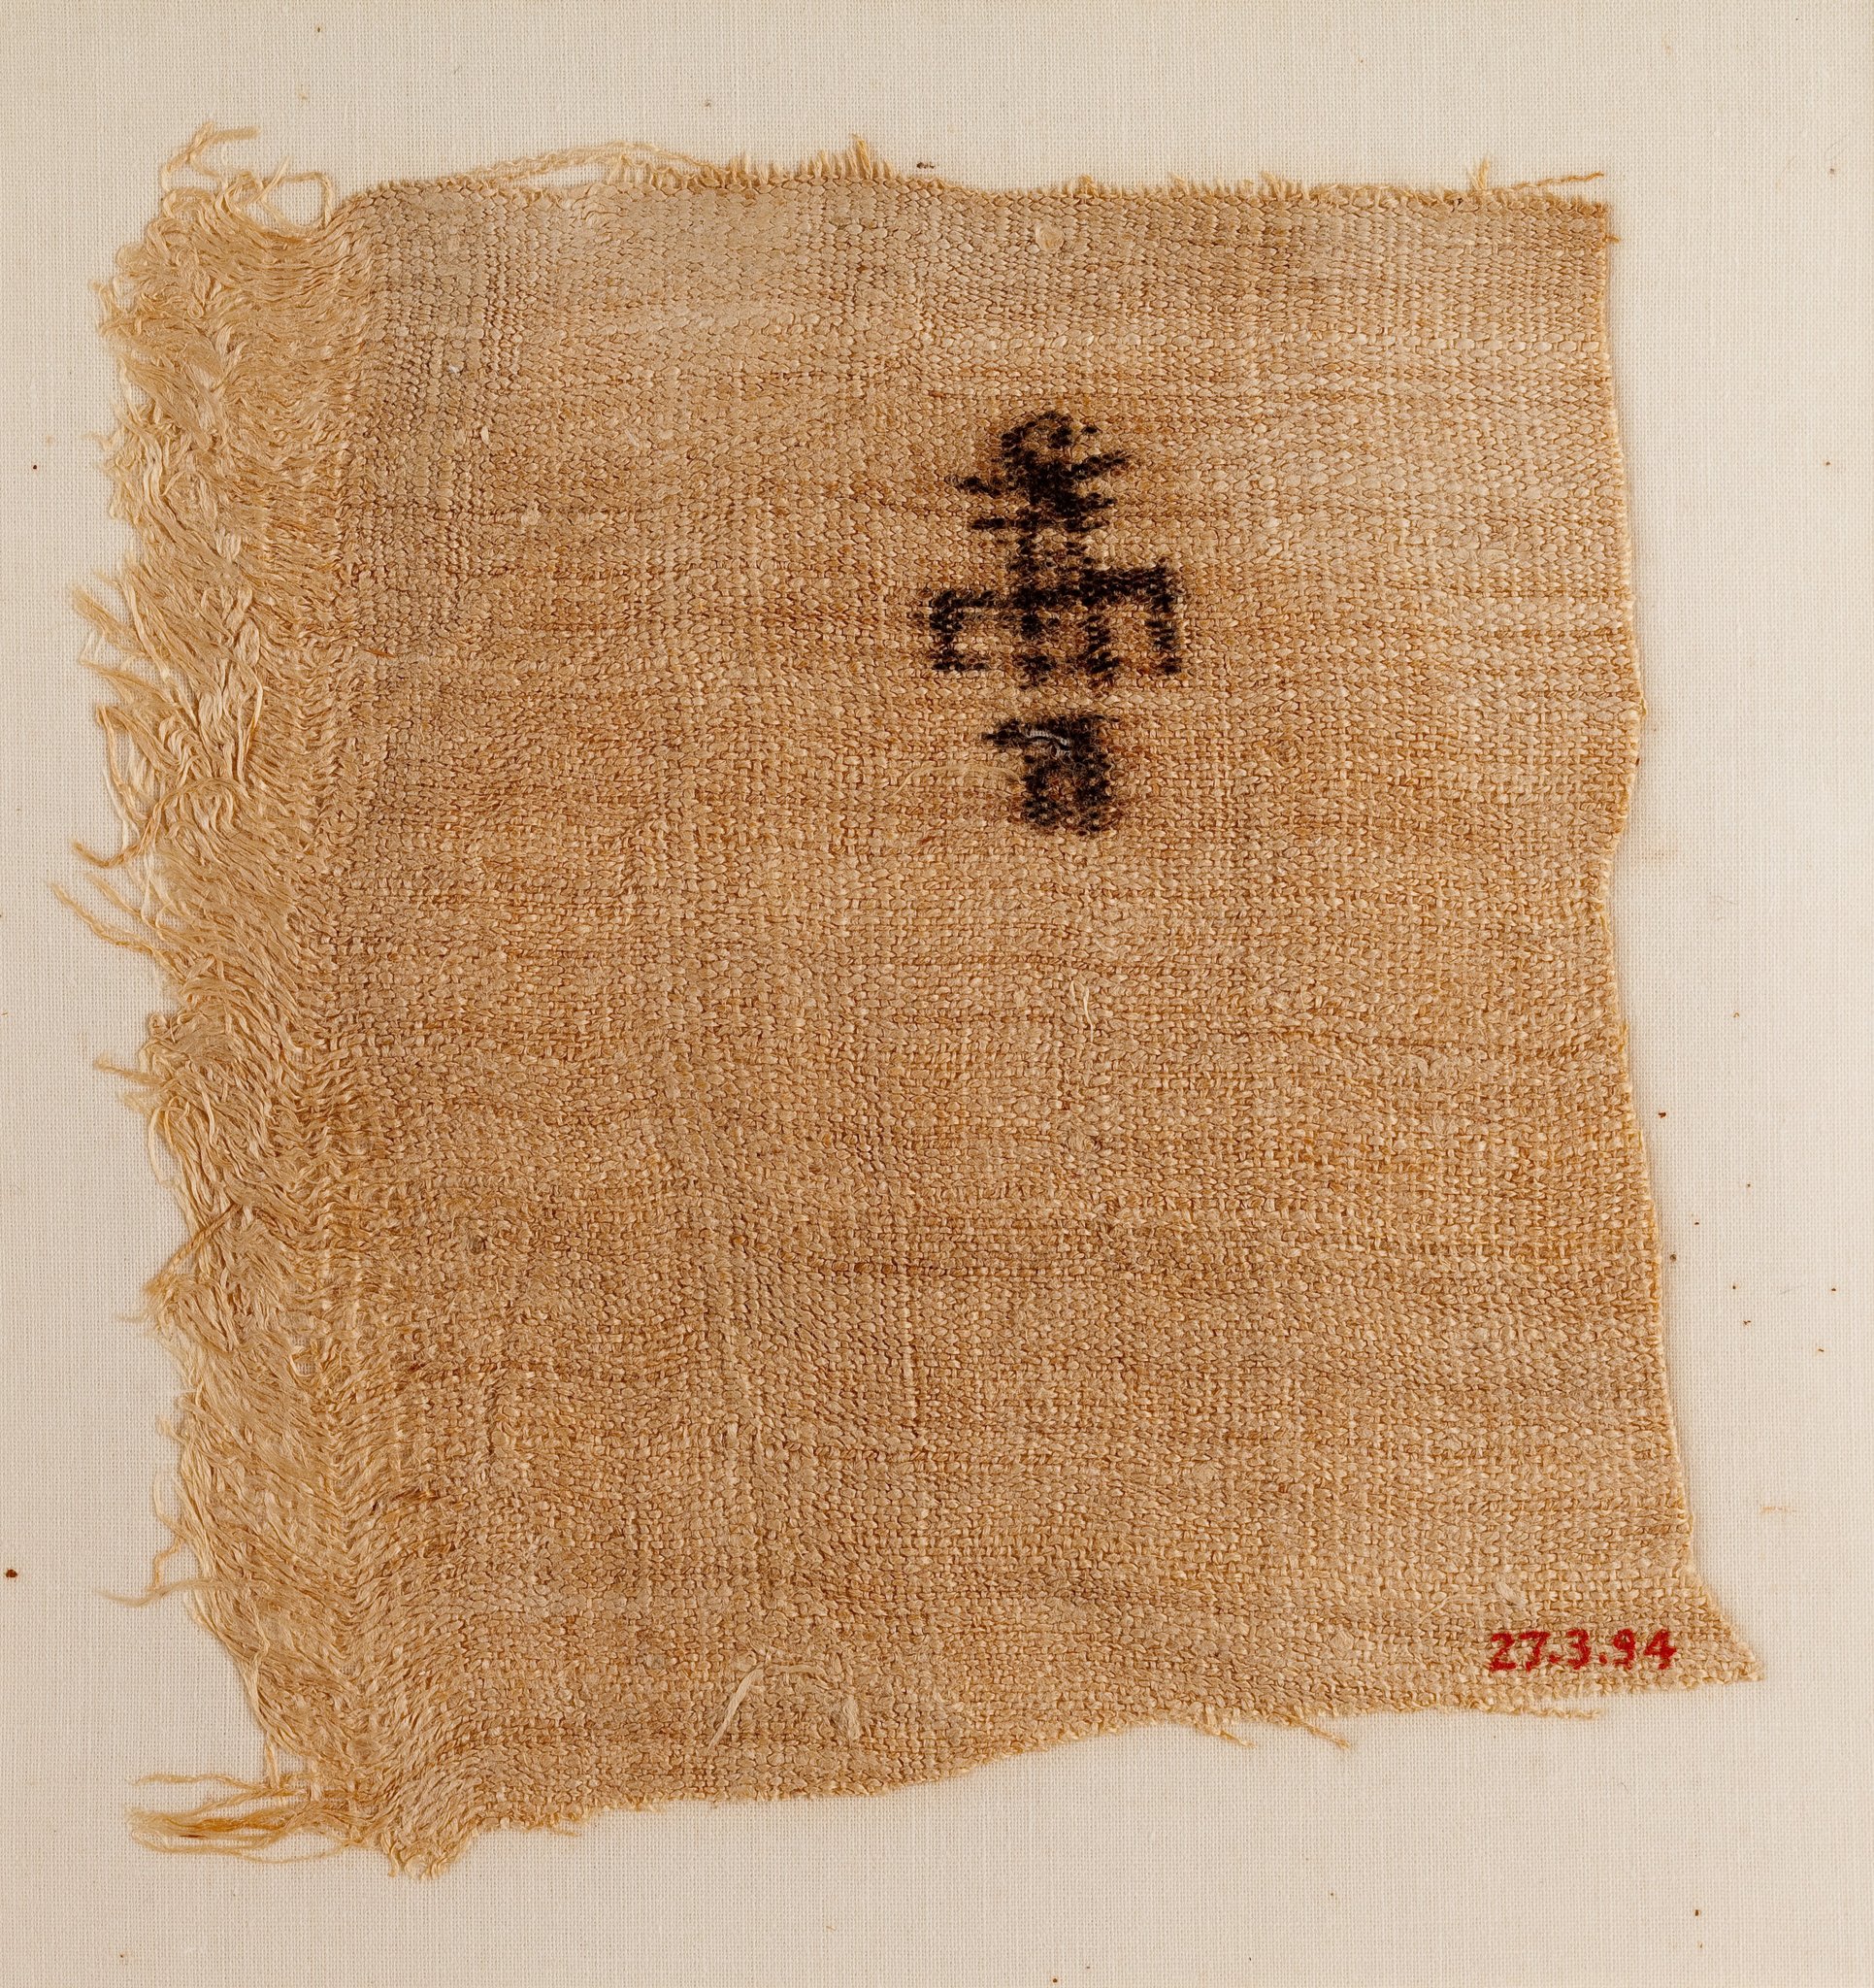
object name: linen mark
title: Linen mark (Type IV)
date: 1961-1917 BCE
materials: linen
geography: egypt